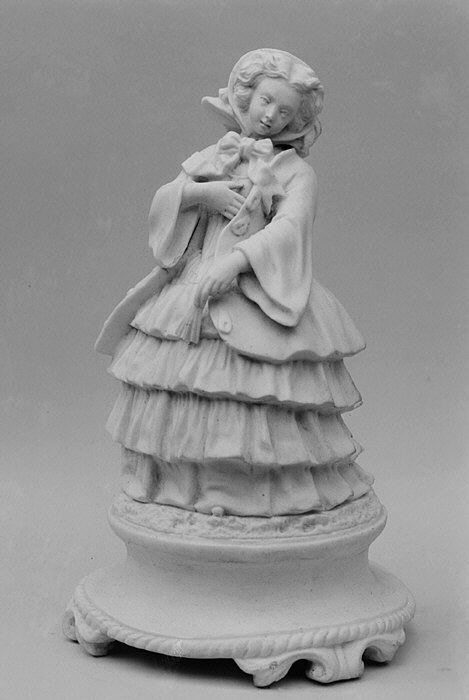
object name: figure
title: Woman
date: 1850-1870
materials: biscuit, paste, porcelain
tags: women